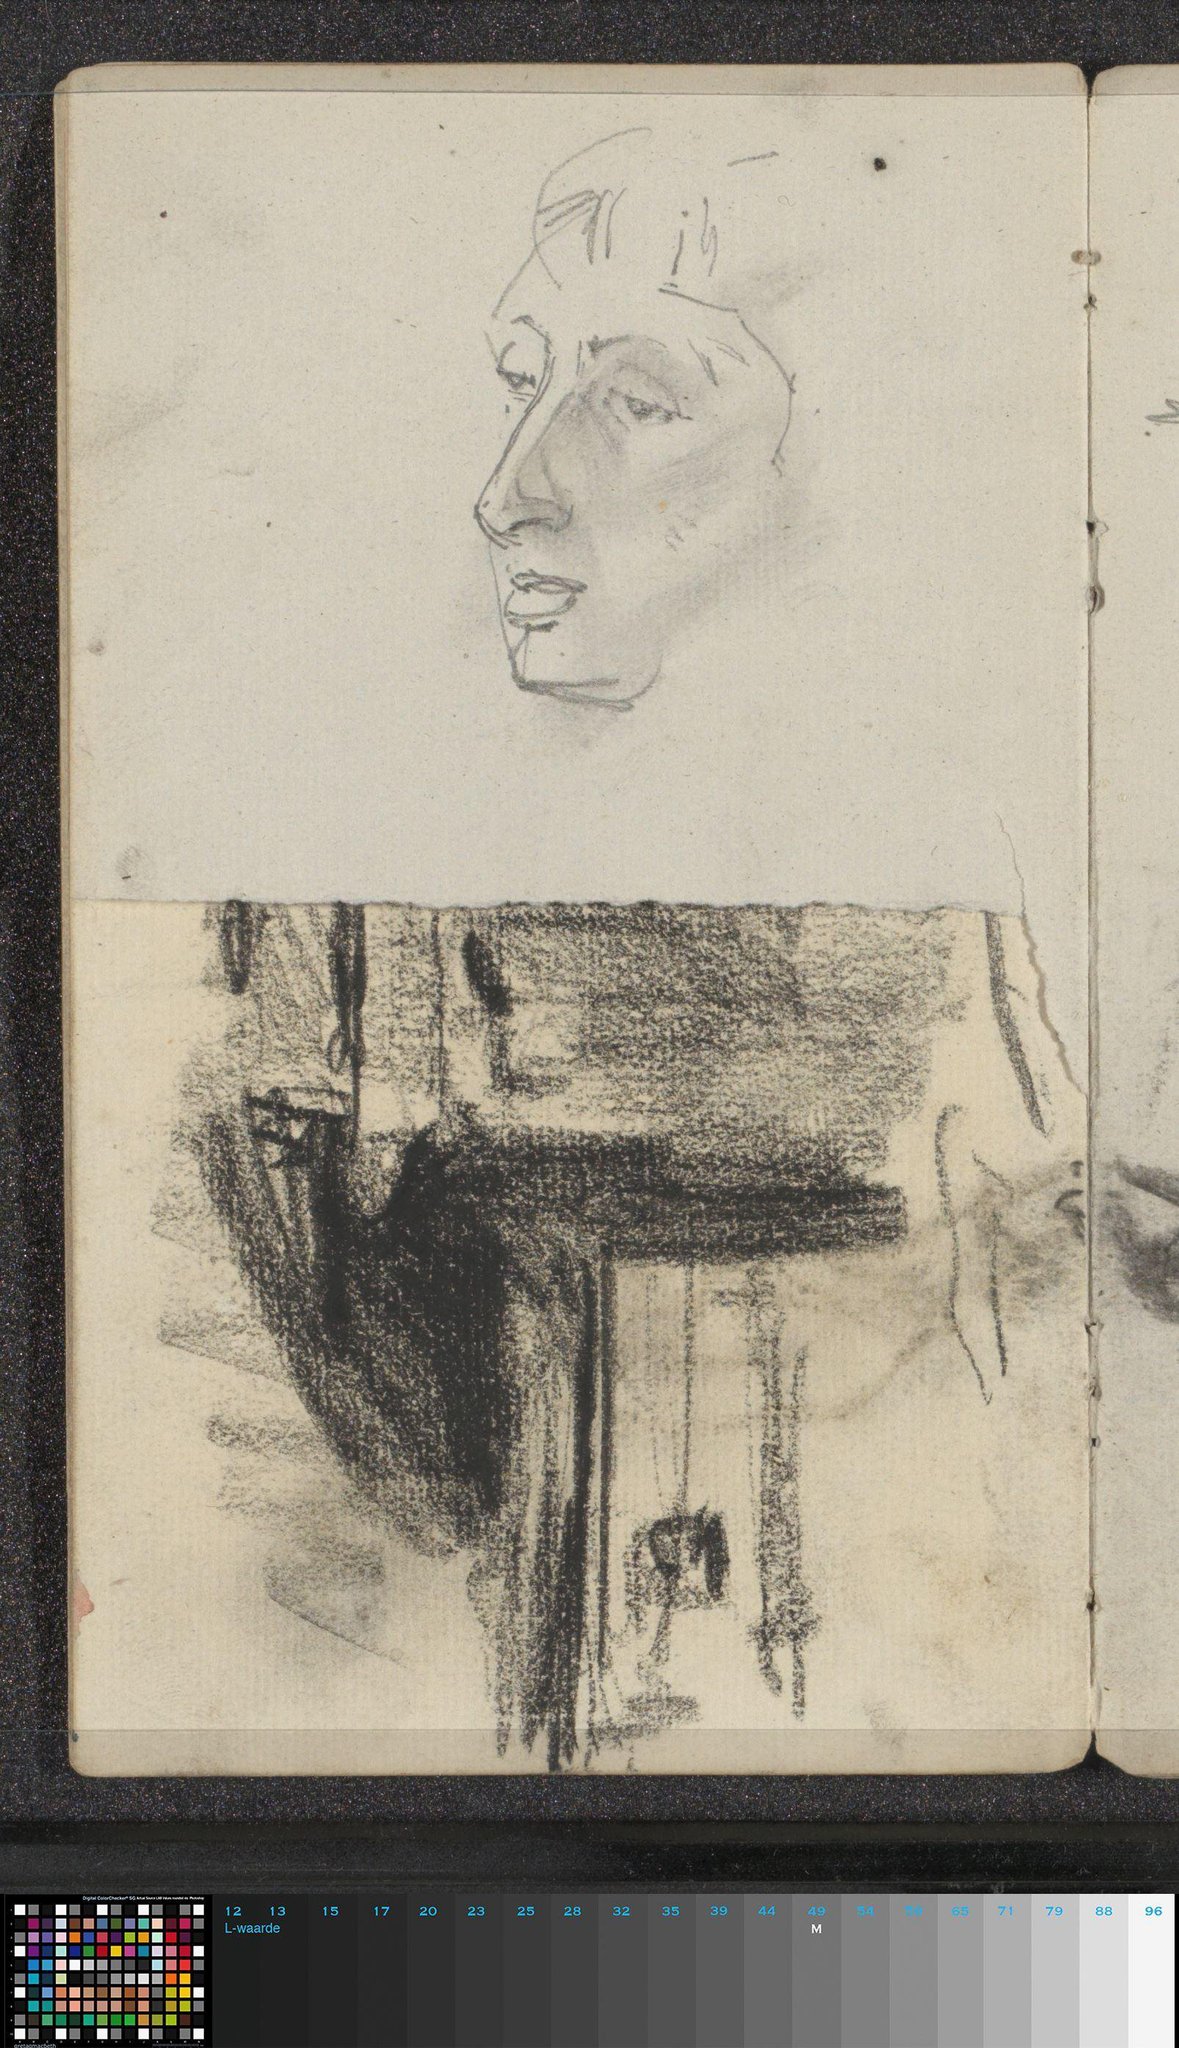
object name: sketchbook leaf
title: Gezicht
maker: george hendrik breitner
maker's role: draughtsman, painter, print maker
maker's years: 1857-1923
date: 1887-1889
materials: paper, pencil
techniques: stumping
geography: amsterdam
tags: face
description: Pagina 17 uit een schetsboek met 27 bladen.